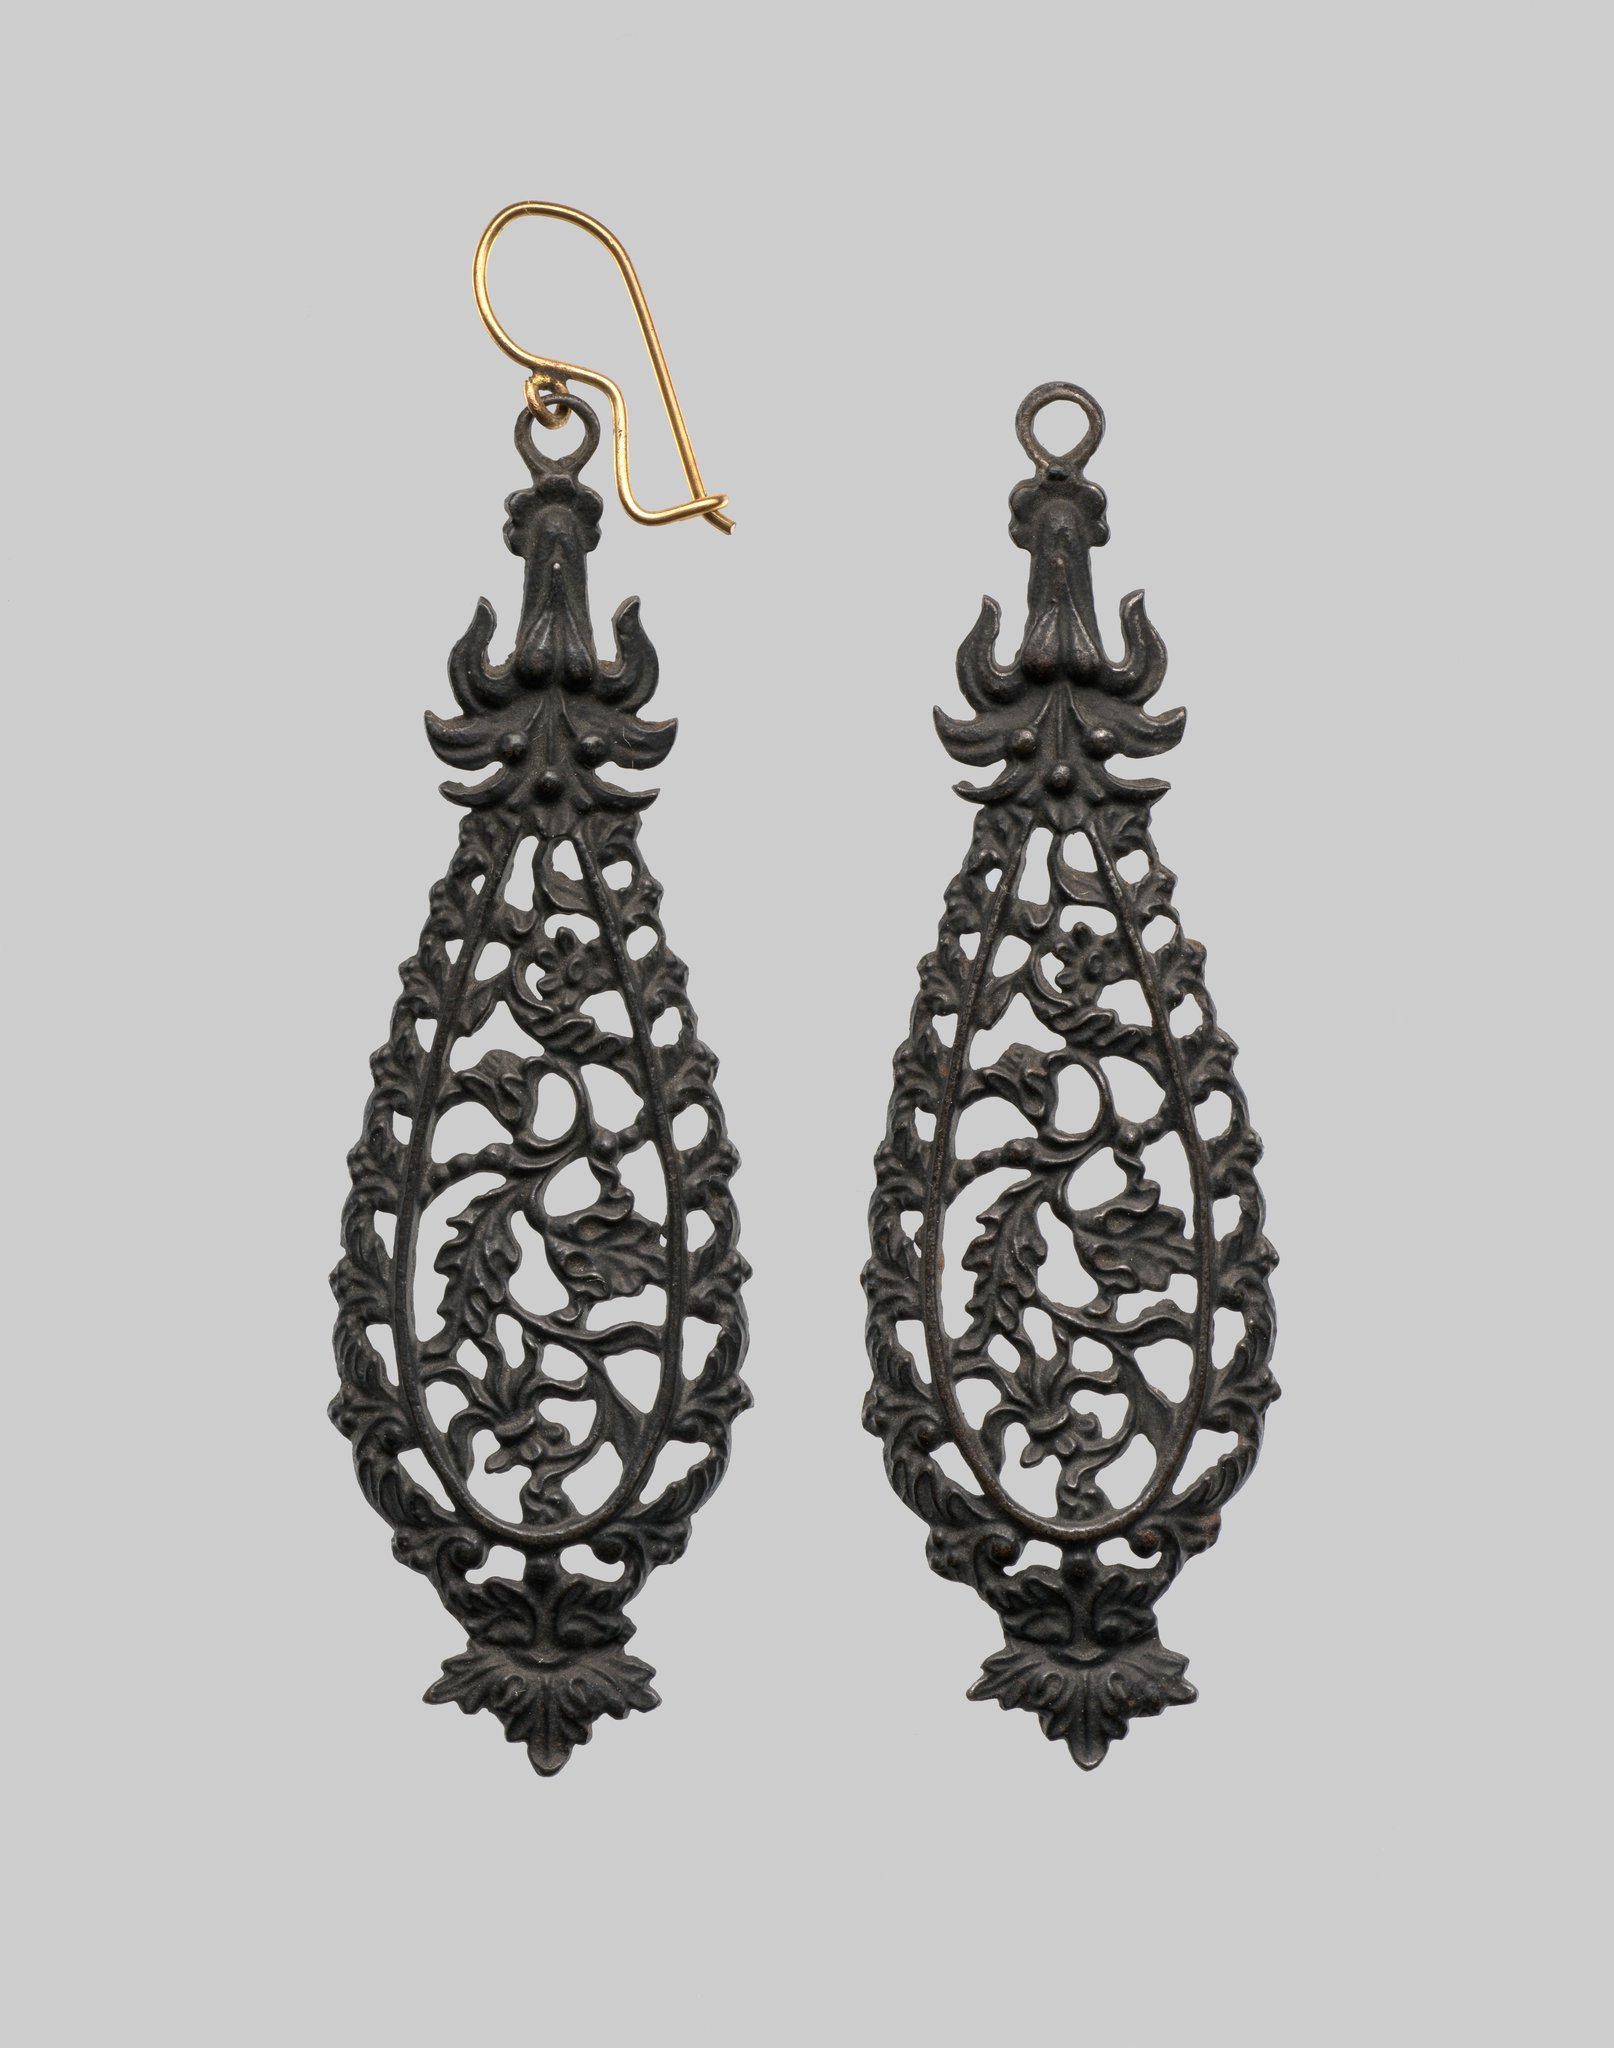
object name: earring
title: Pair of earrings (part of a set)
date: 1801-1833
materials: iron